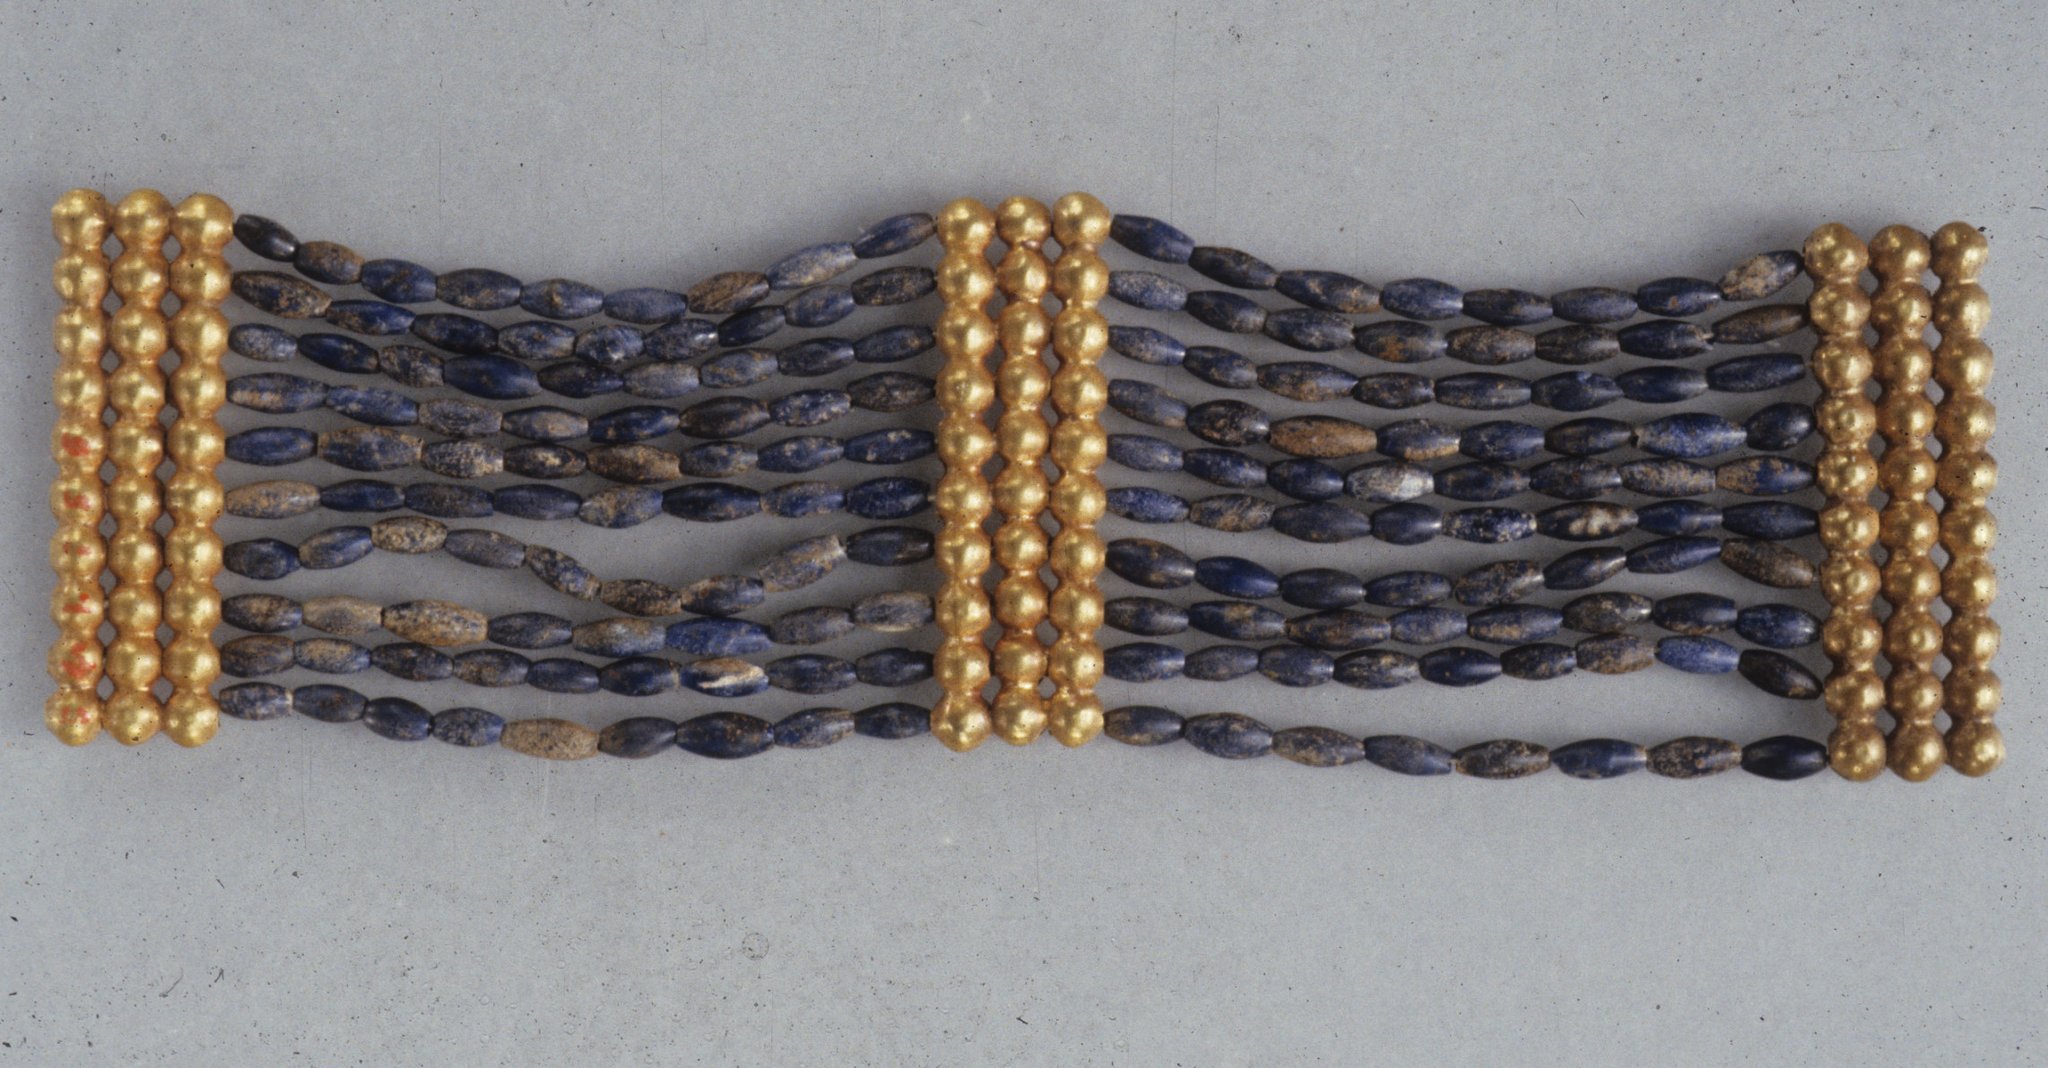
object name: bracelet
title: Bracelet of Hepy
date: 1950-1885 BCE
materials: gold, lapis lazuli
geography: egypt